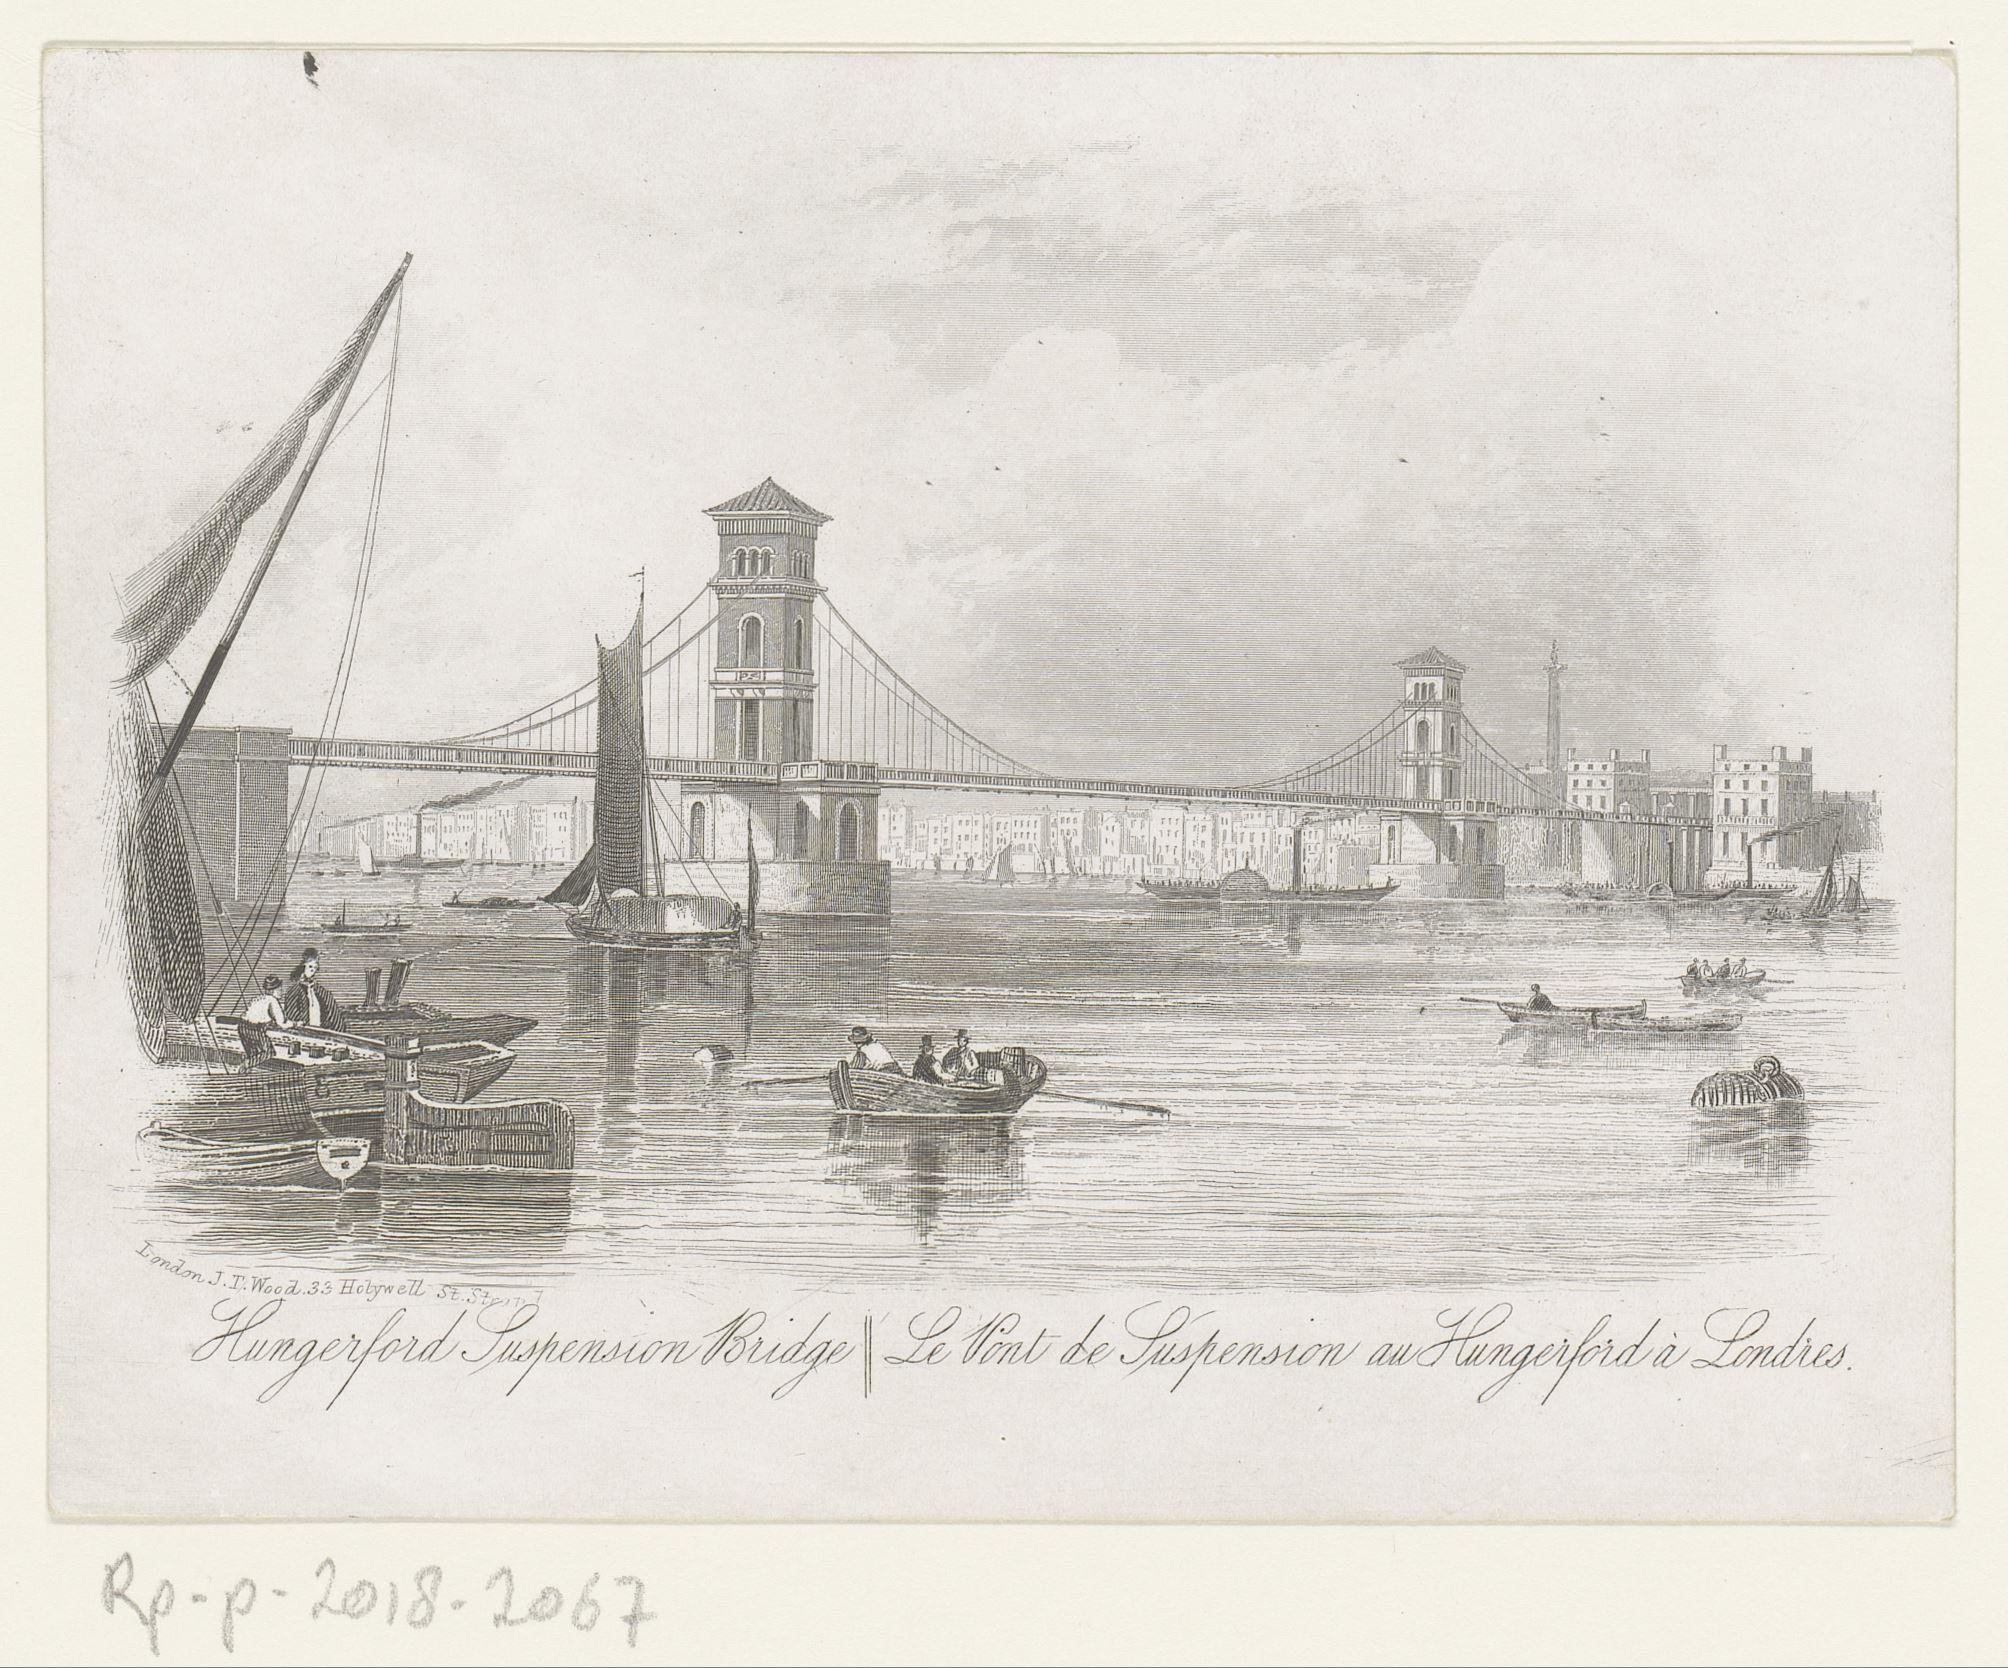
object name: print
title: Gezicht op Hungerford Bridge, te Londen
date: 1841-1885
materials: paper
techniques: etching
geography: london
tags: suspension bridge